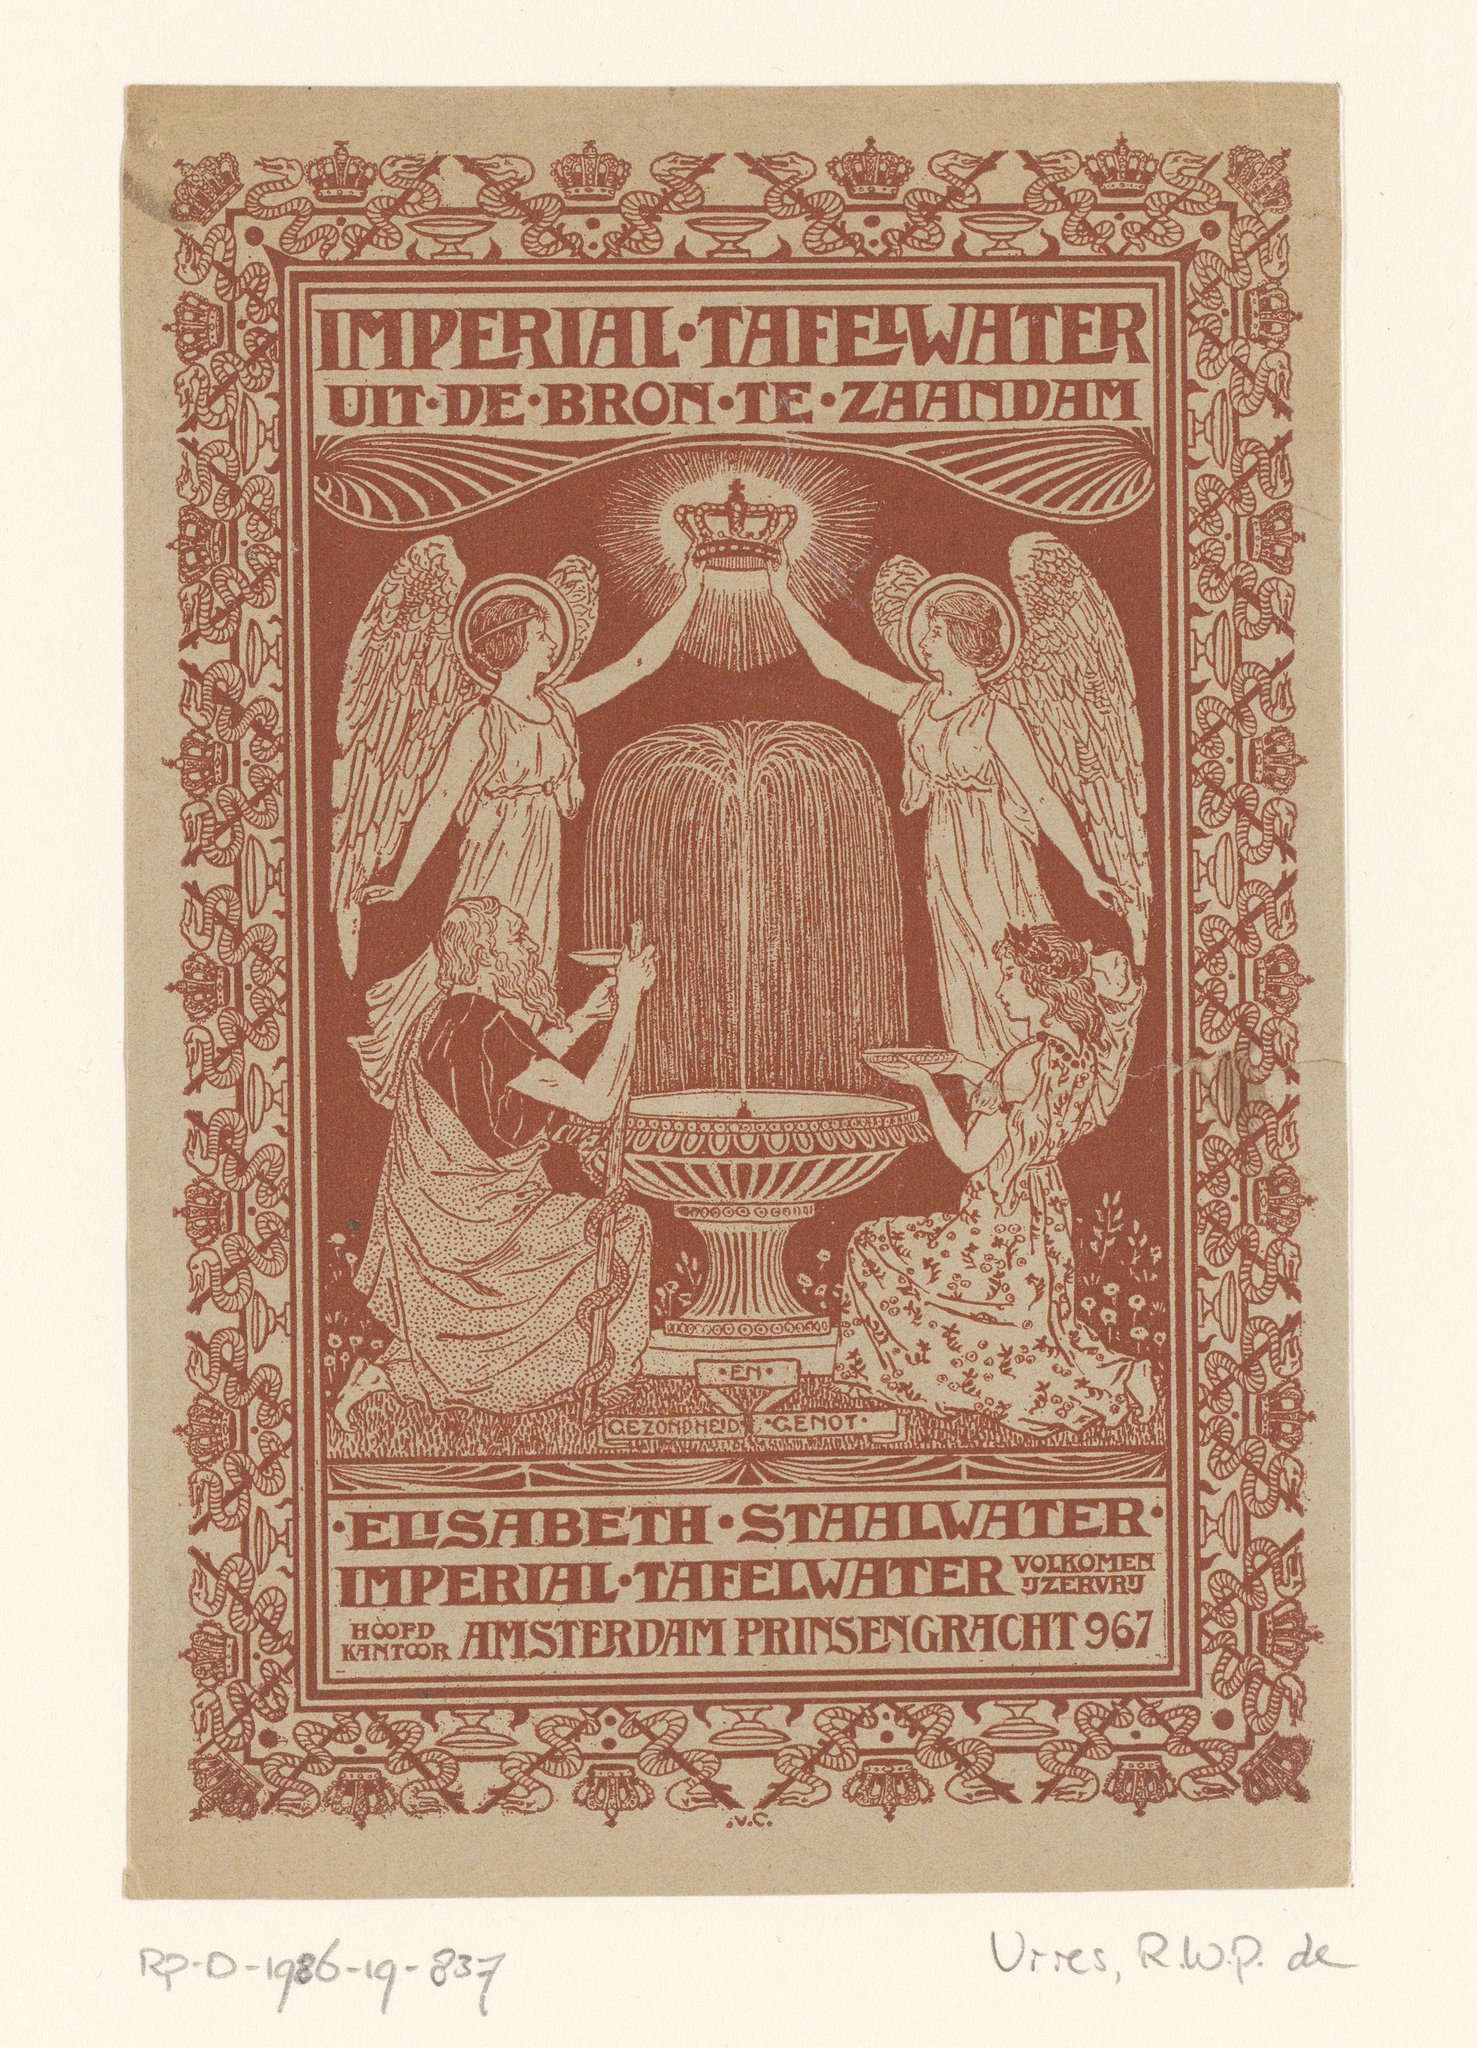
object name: advertisement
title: Advertentie voor Imperial tafelwater uit Zaandam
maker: johann georg van caspel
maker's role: draughtsman, print maker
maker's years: 1870-1928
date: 1880-1928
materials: paper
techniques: lithograph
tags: well, aesculapian sign, angels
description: Twee engelen houden samen een kroon vast boven een waterbron. Bij de bron knielt een jonge vrouw in een gebloemde jurk met een kom. Aan de overzijde knielt een oudere man met baard en esculaap. Hij heeft een kelk in zijn hand.